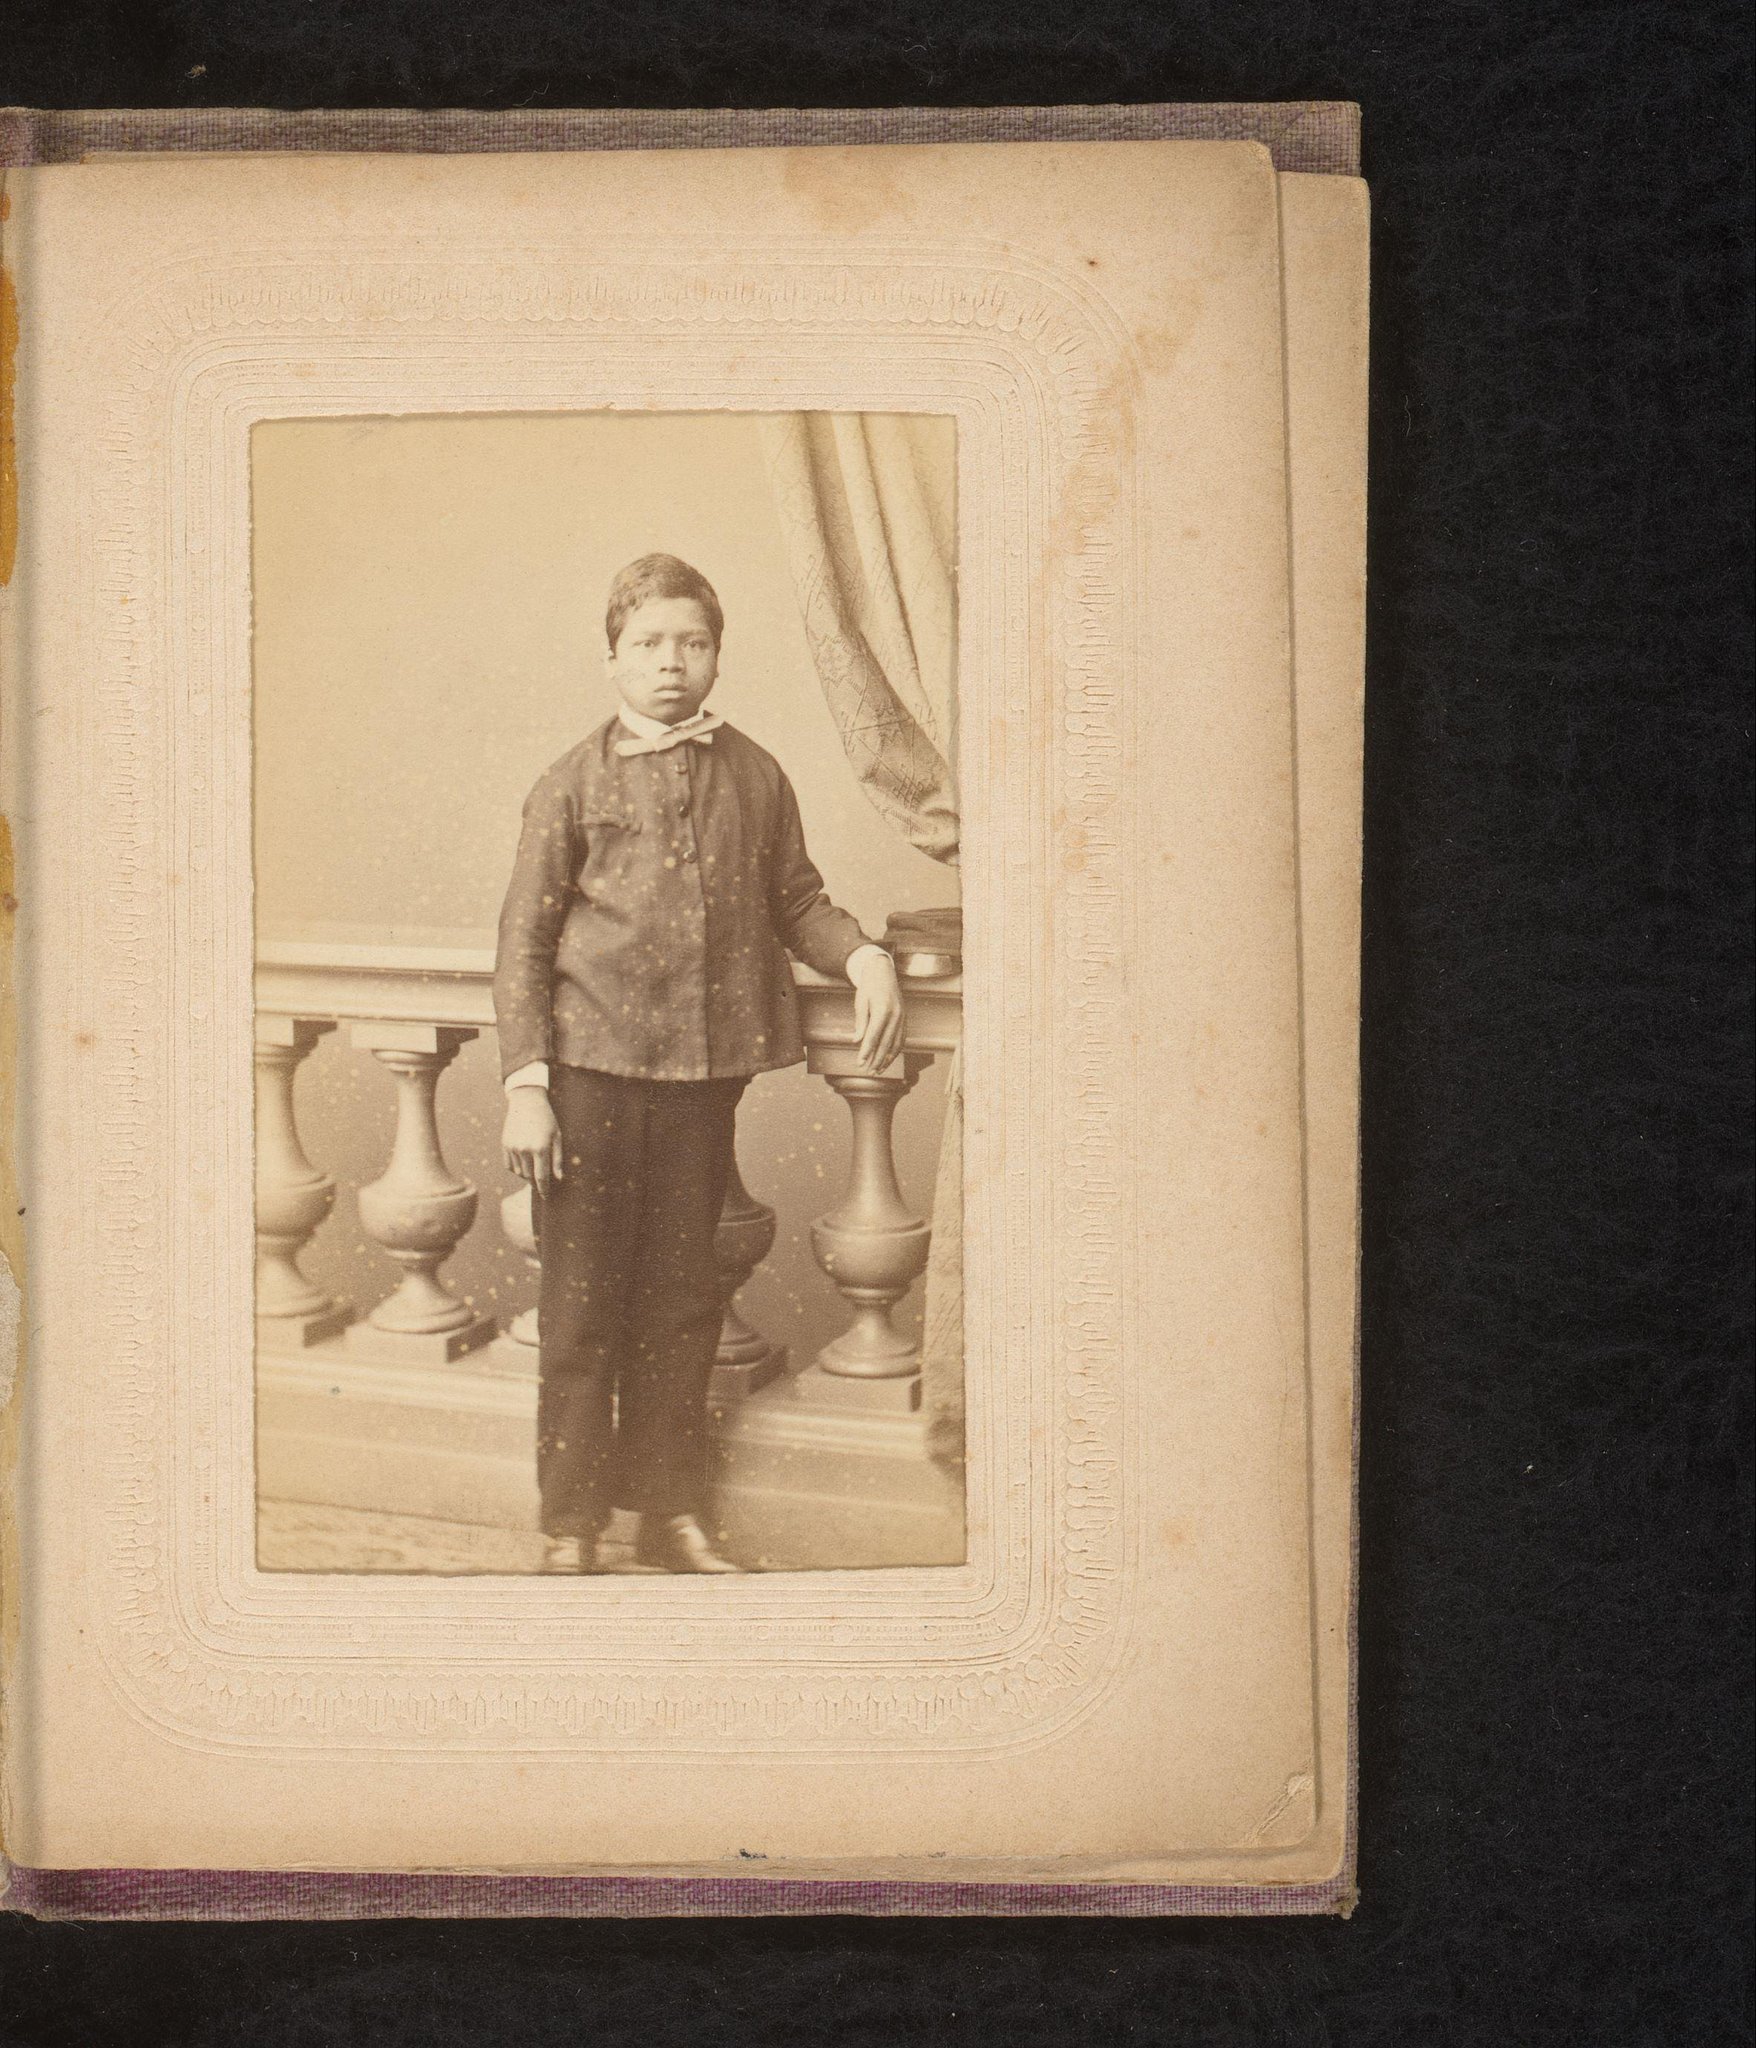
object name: carte de visite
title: Portret van een jongen, staand bij een balustrade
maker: jacobus van gorkom (jr.)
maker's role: print maker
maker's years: 1827-1880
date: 1862-1871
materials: cardboard, photographic support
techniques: albumen print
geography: rotterdam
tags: boy (child between toddler and youth), historical persons, balustrade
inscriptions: inscription: ‘J. van GORKOM Jr./ PHOTOGRAPHE/KRUISKADE/ WIJK 14. 592./ ROTTERDAM’